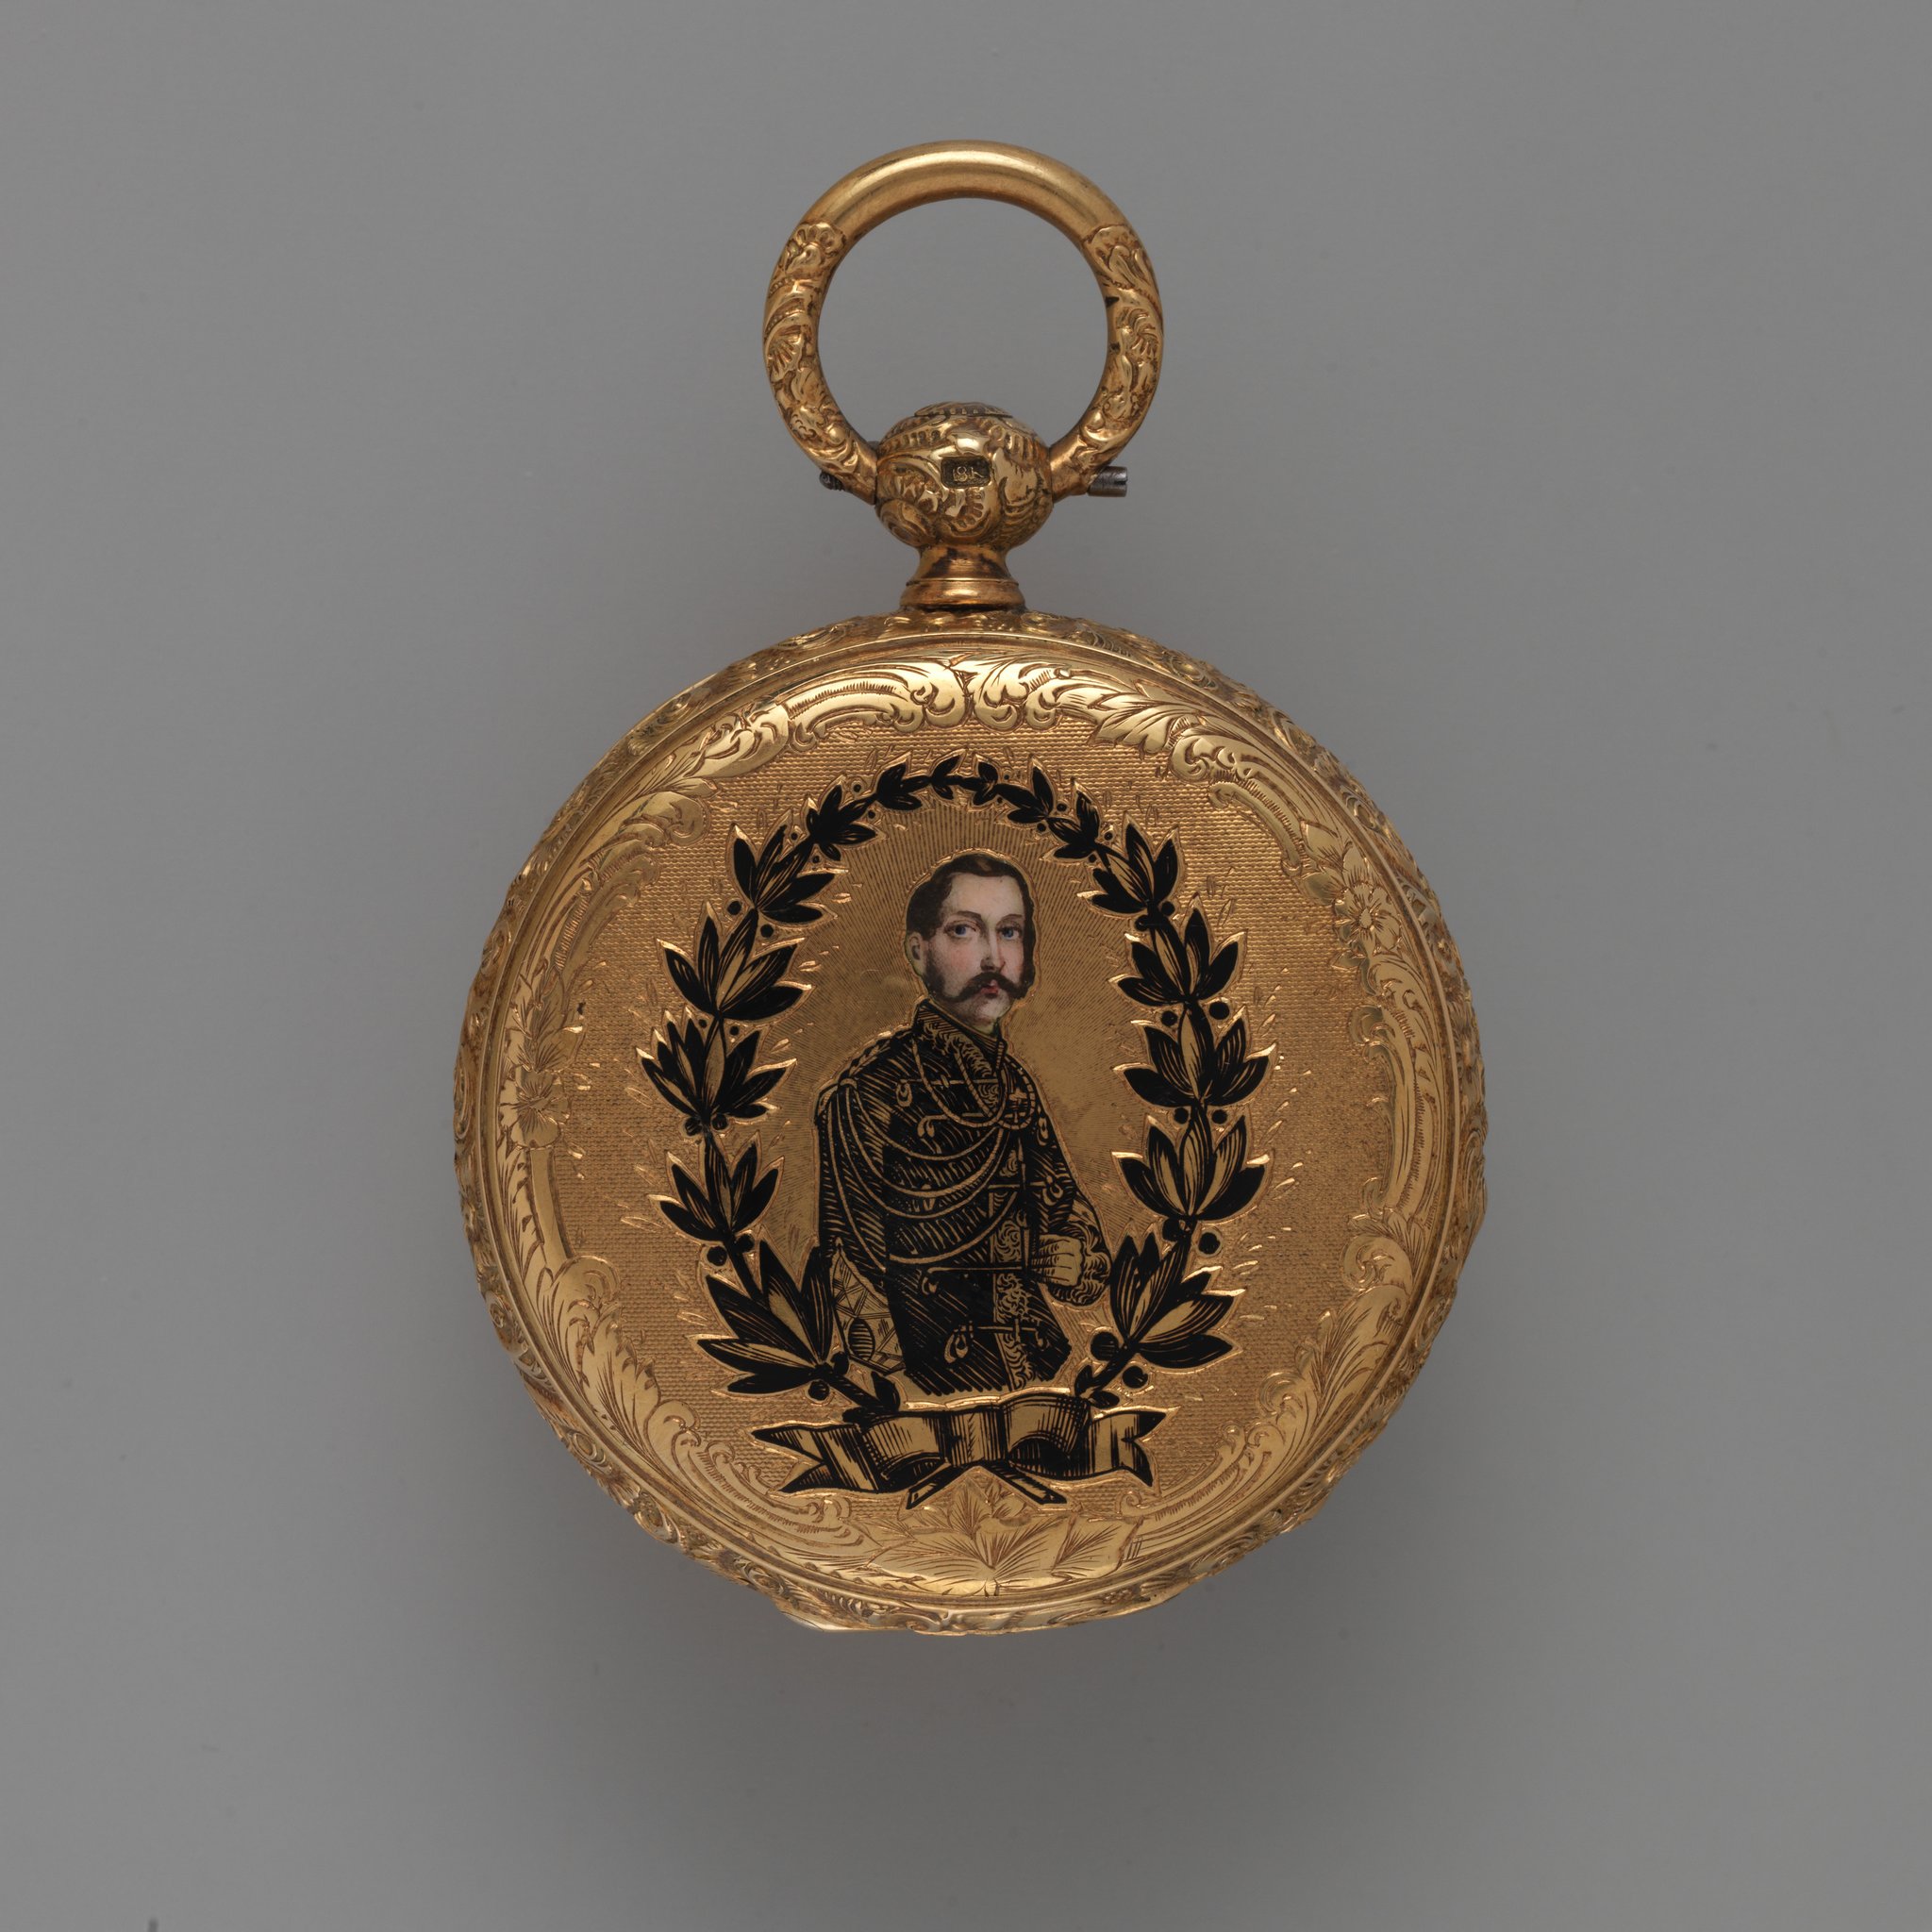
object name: watch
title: Watch, with a portrait of Alexander II, czar of Russia (r. 1855–81)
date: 1860-1870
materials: enamel, gold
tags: eagles,men,portraits,coat of arms